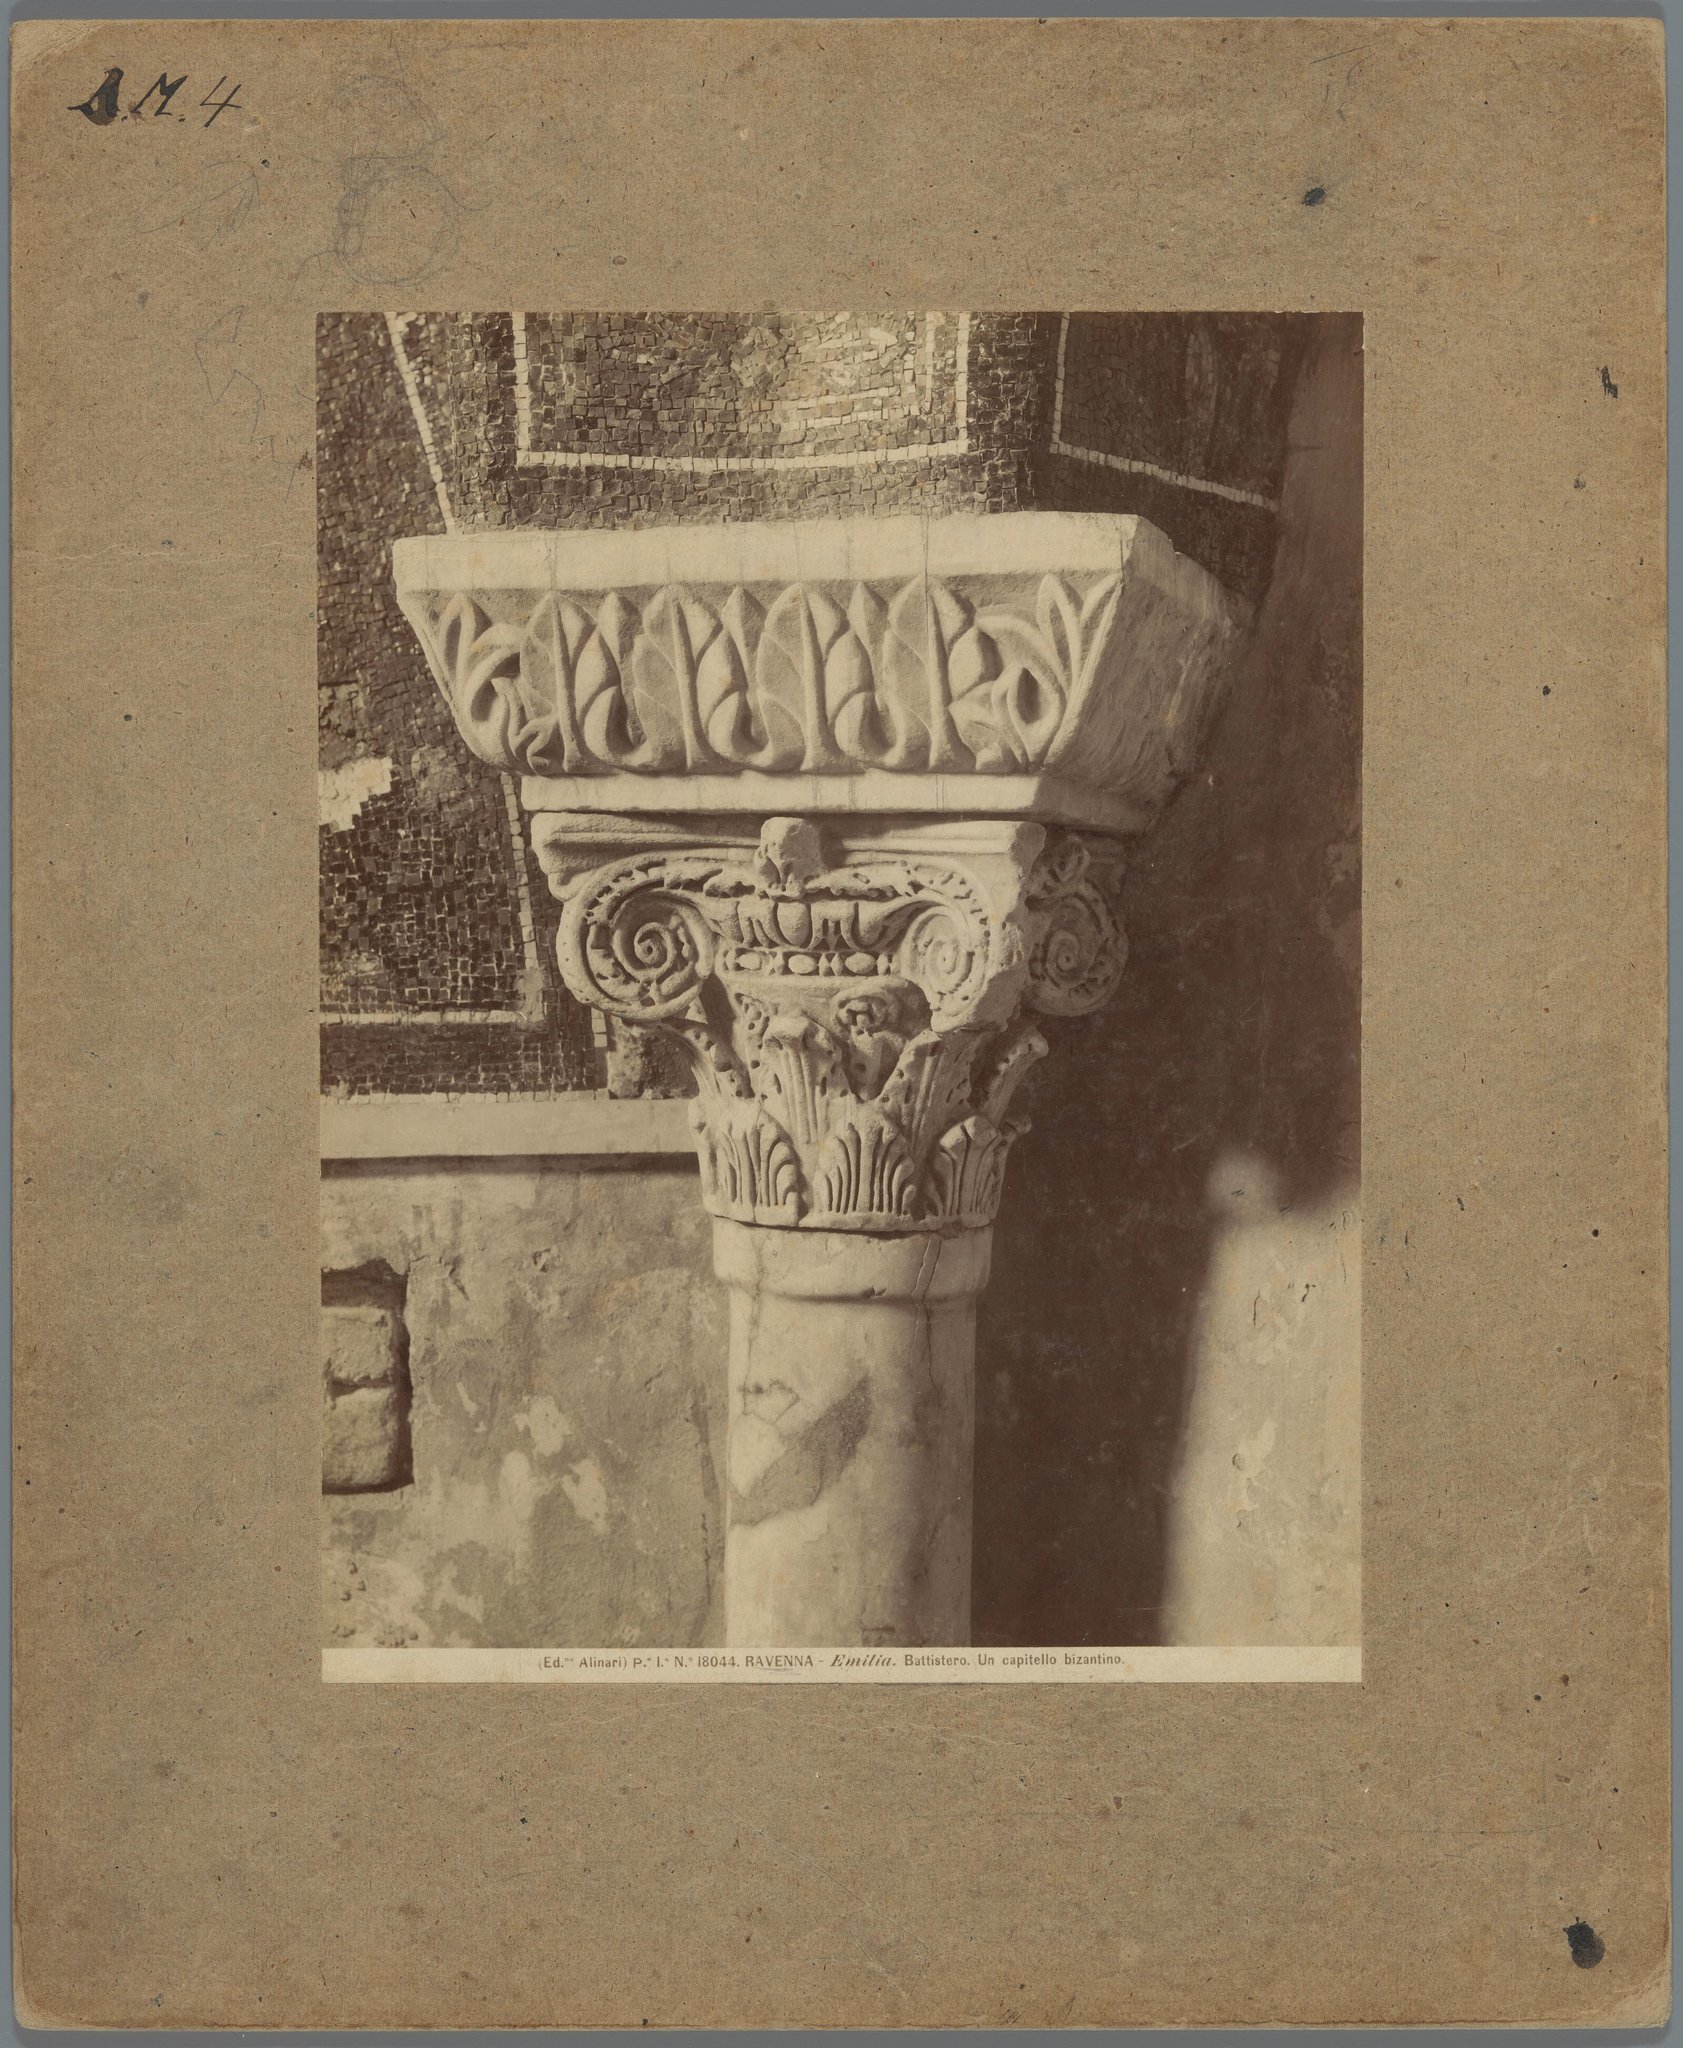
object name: photograph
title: Kapiteel van een zuil in een baptisterium te Ravenna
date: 1875-1900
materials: cardboard, photographic support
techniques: albumen print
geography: ravenna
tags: capital (~ column, pillar)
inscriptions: inscription: ‘R.M. 4’, annotation, number: ‘P.e I.a N.o 18044.’, collector's mark: Lugt 3937